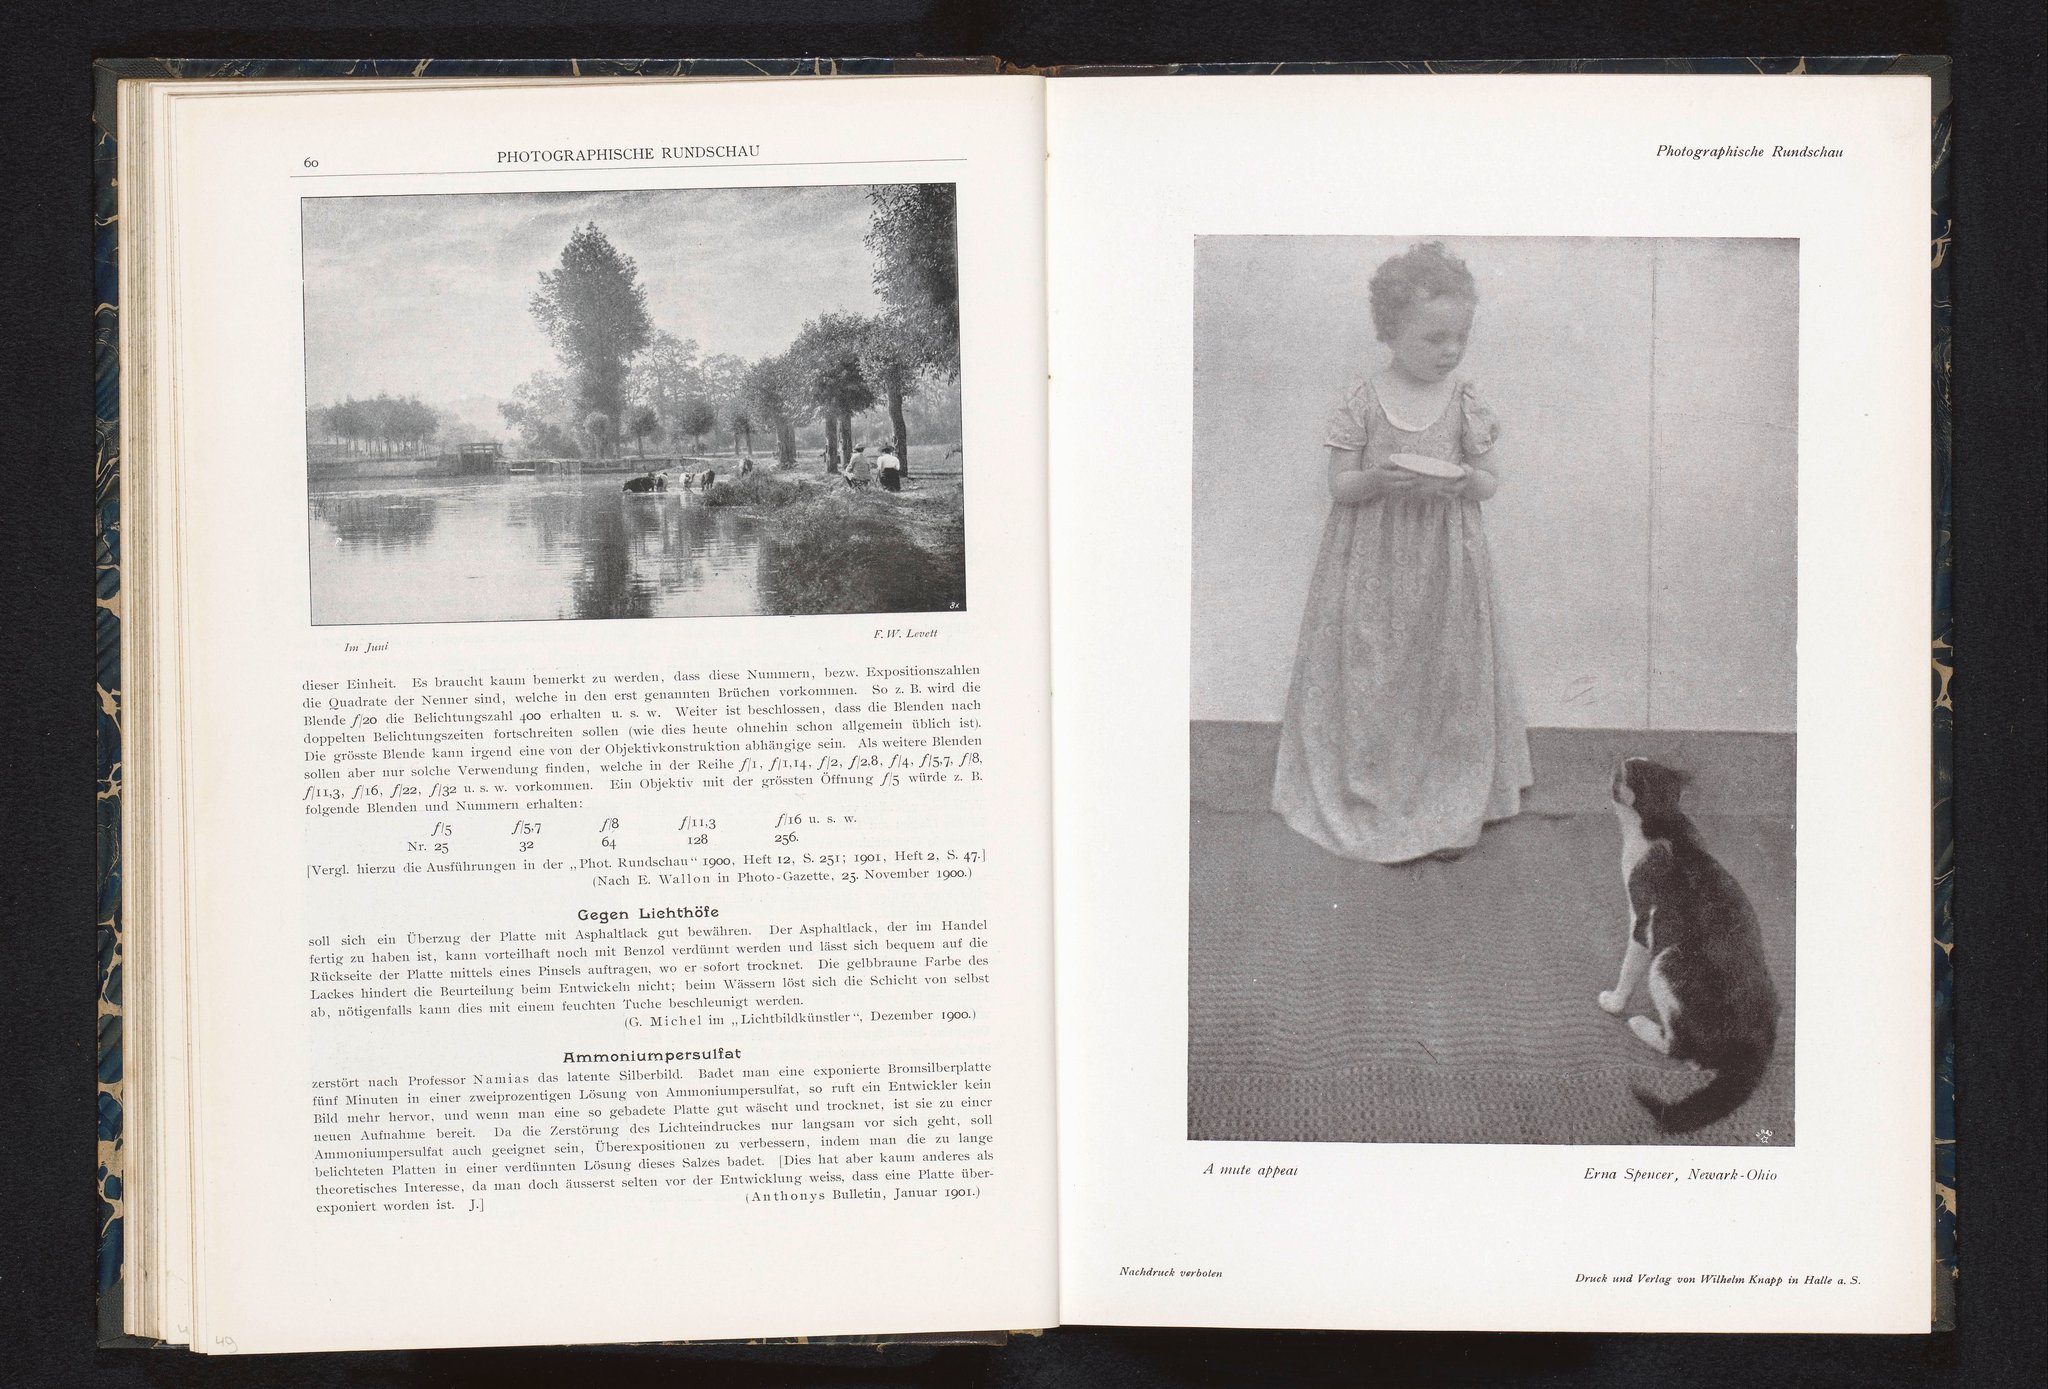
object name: page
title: Koeien in een rivier, met twee personen op krukjes op de kade die toekijken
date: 1896-1901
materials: paper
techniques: autotype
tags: cow, river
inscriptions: monogram: ‘BX’